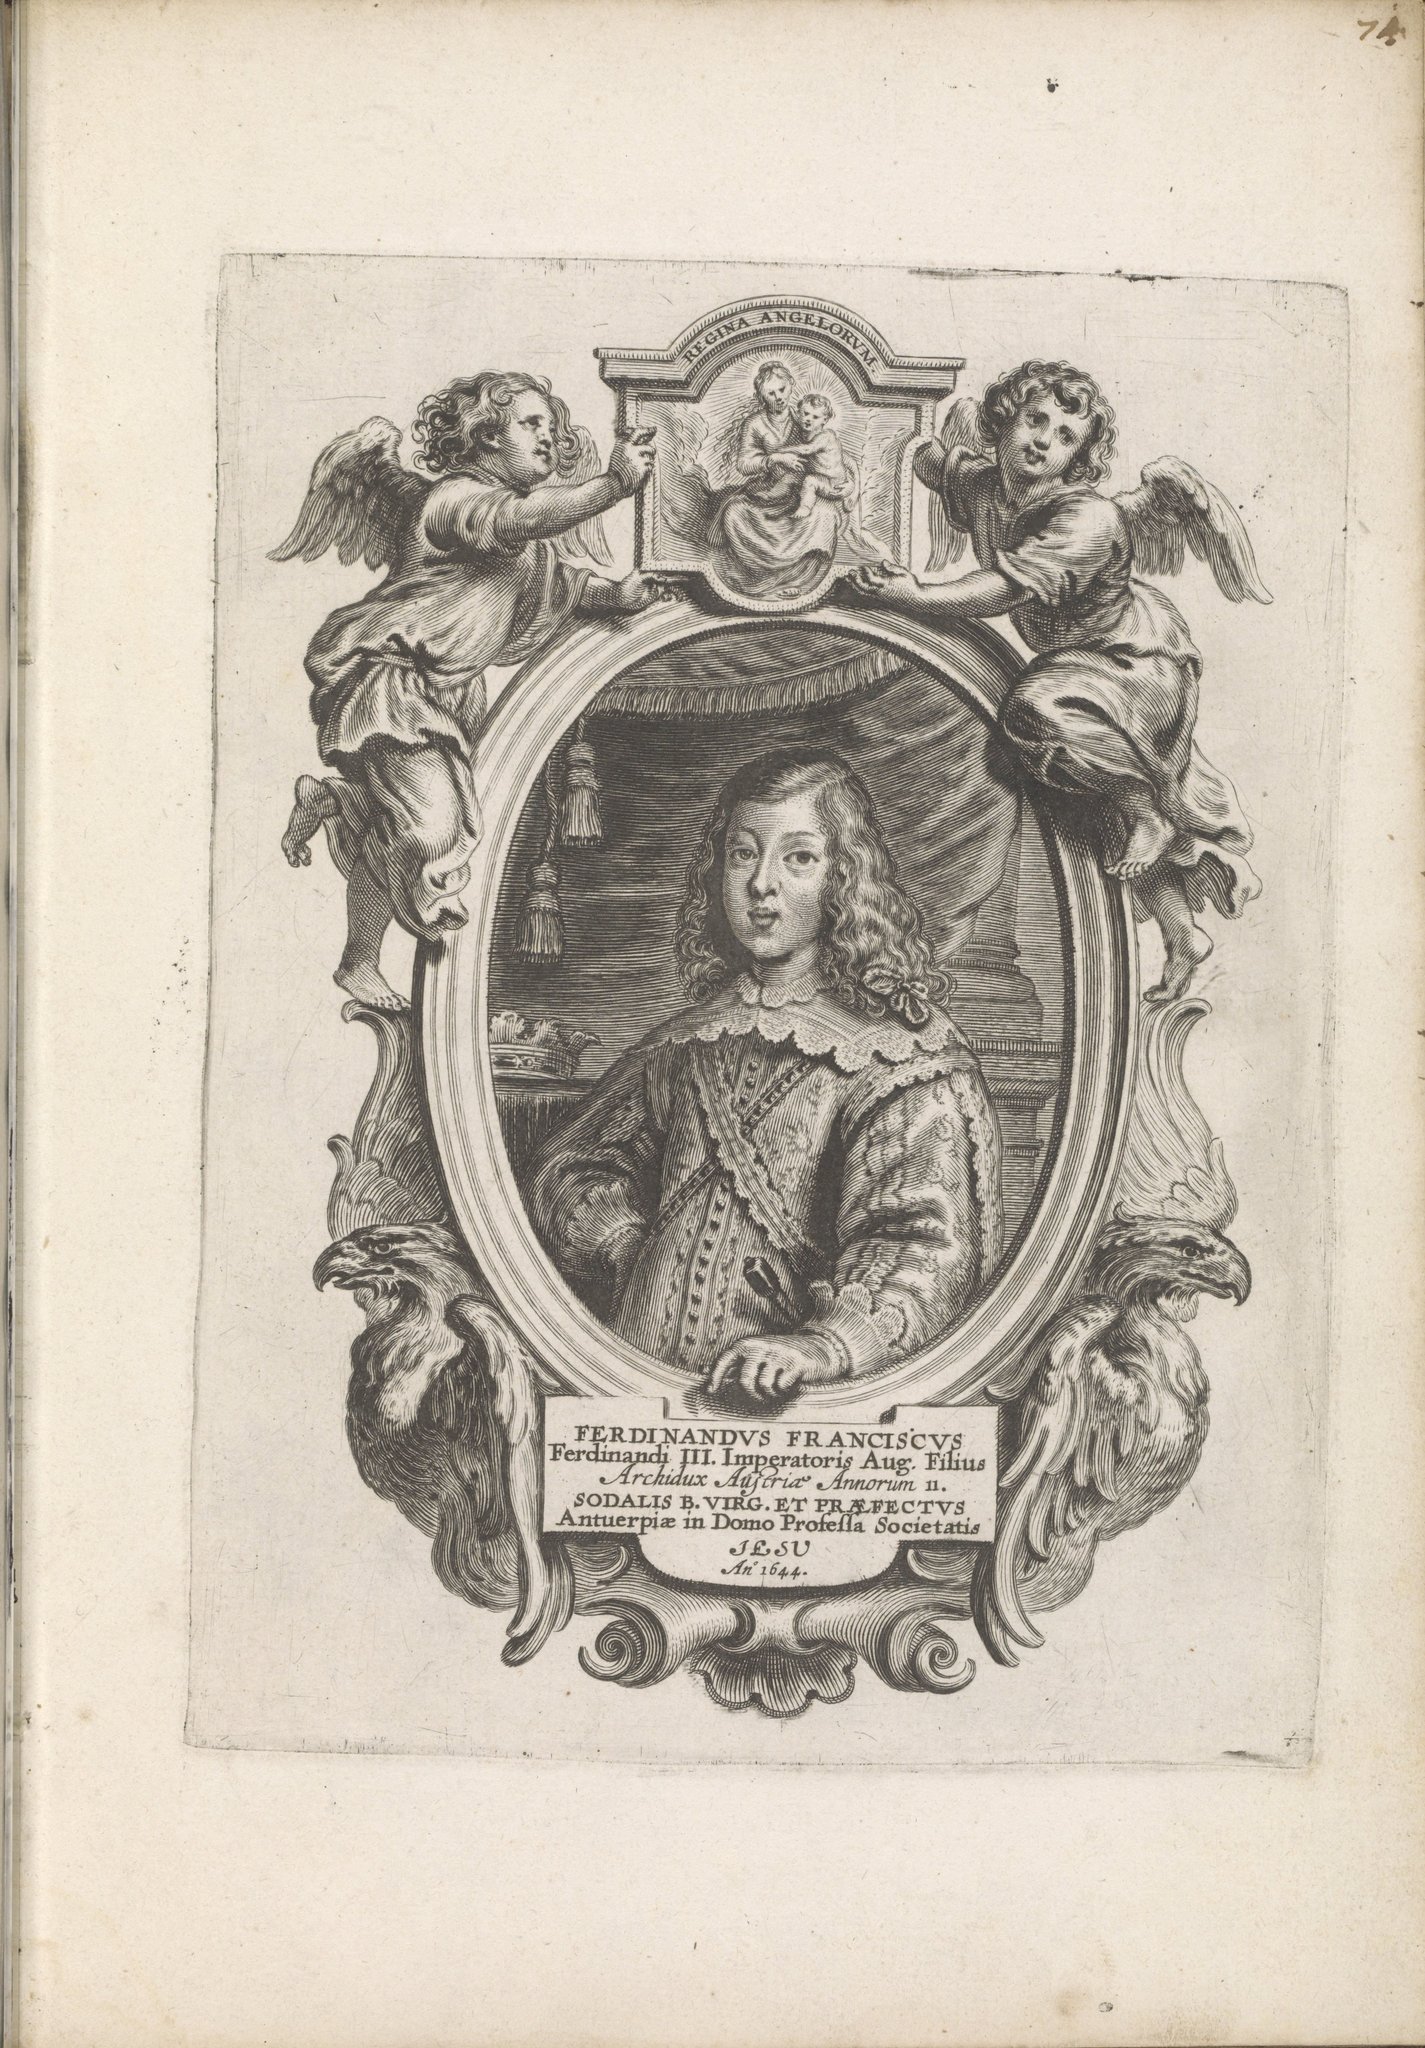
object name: print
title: Portret van Ferdinand IV, koning van Hongarije, Bohemen en het Heilige Roomse Rijk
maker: Anonymous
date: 1644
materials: paper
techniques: engraving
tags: vienna, crown (symbol of sovereignty), ornament ~ cartouche (+ ornament enlivened by animal forms)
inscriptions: date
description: Portret van Ferdinand Franciscus (Ferdinand IV, koning van Hongarije, Bohemen en het Heilige Roomse Rijk), oudtste zoon van keizer Ferdinand III. Hij houdt zijn linkerhand in zijn zij en met zijn rechterhand wijst hij naar het kader onder de omlijsting. Op de achtergrond een kroon. Het portret is gevat in een ovale omlijsting in een cartouche met adelaars en een kroon. Twee engelen tonen bovenaan een voorstelling van Maria met Kind. Prent maakt deel uit van een album.